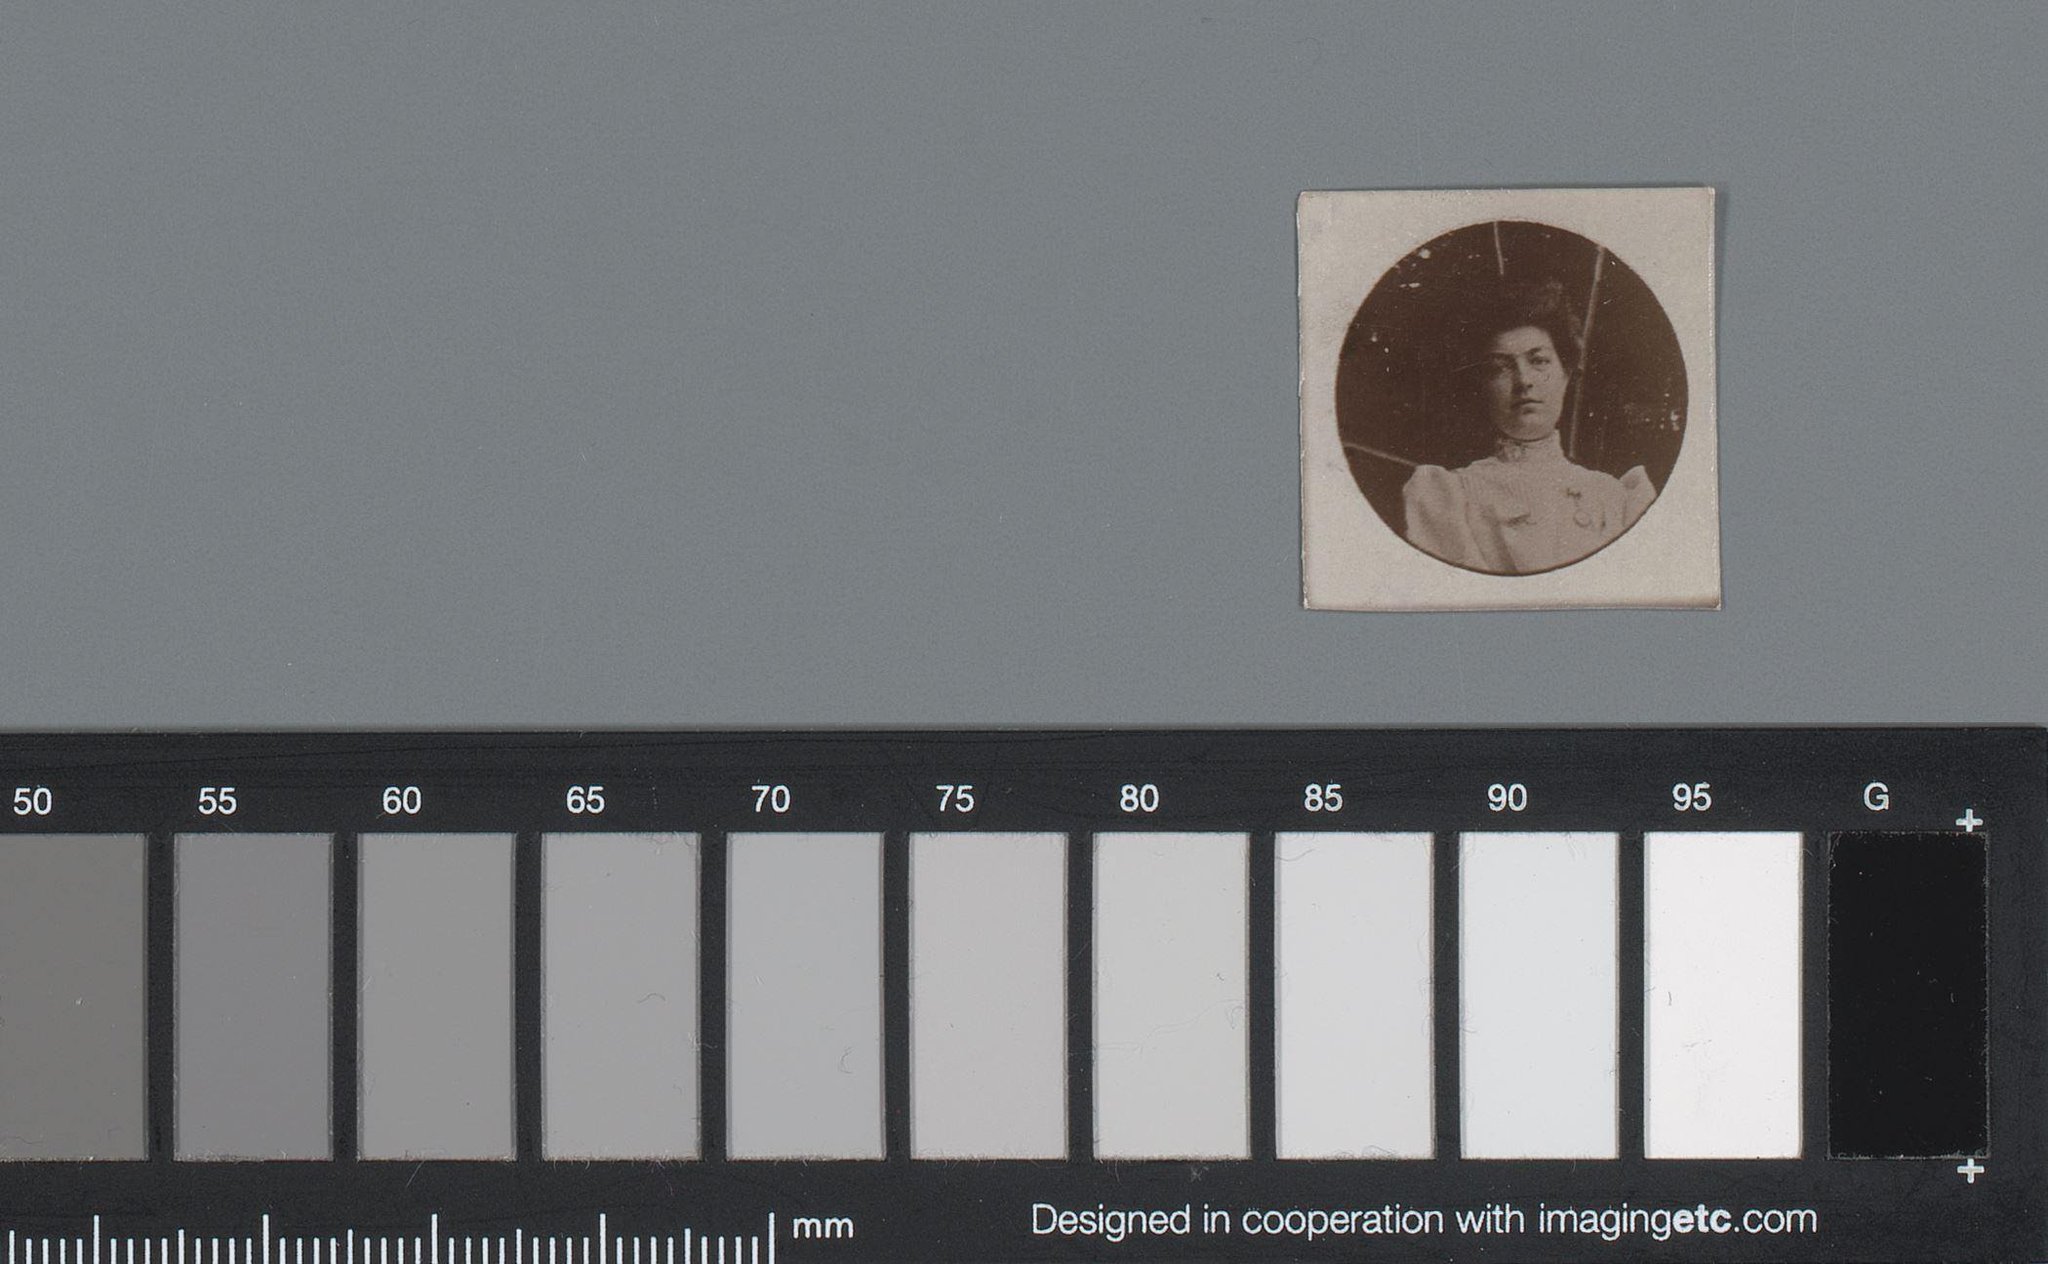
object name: photograph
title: Miniatuurportret van een onbekende vrouw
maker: Anonymous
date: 1890-1930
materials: paper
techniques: gelatin silver print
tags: adolescent, young woman, maiden